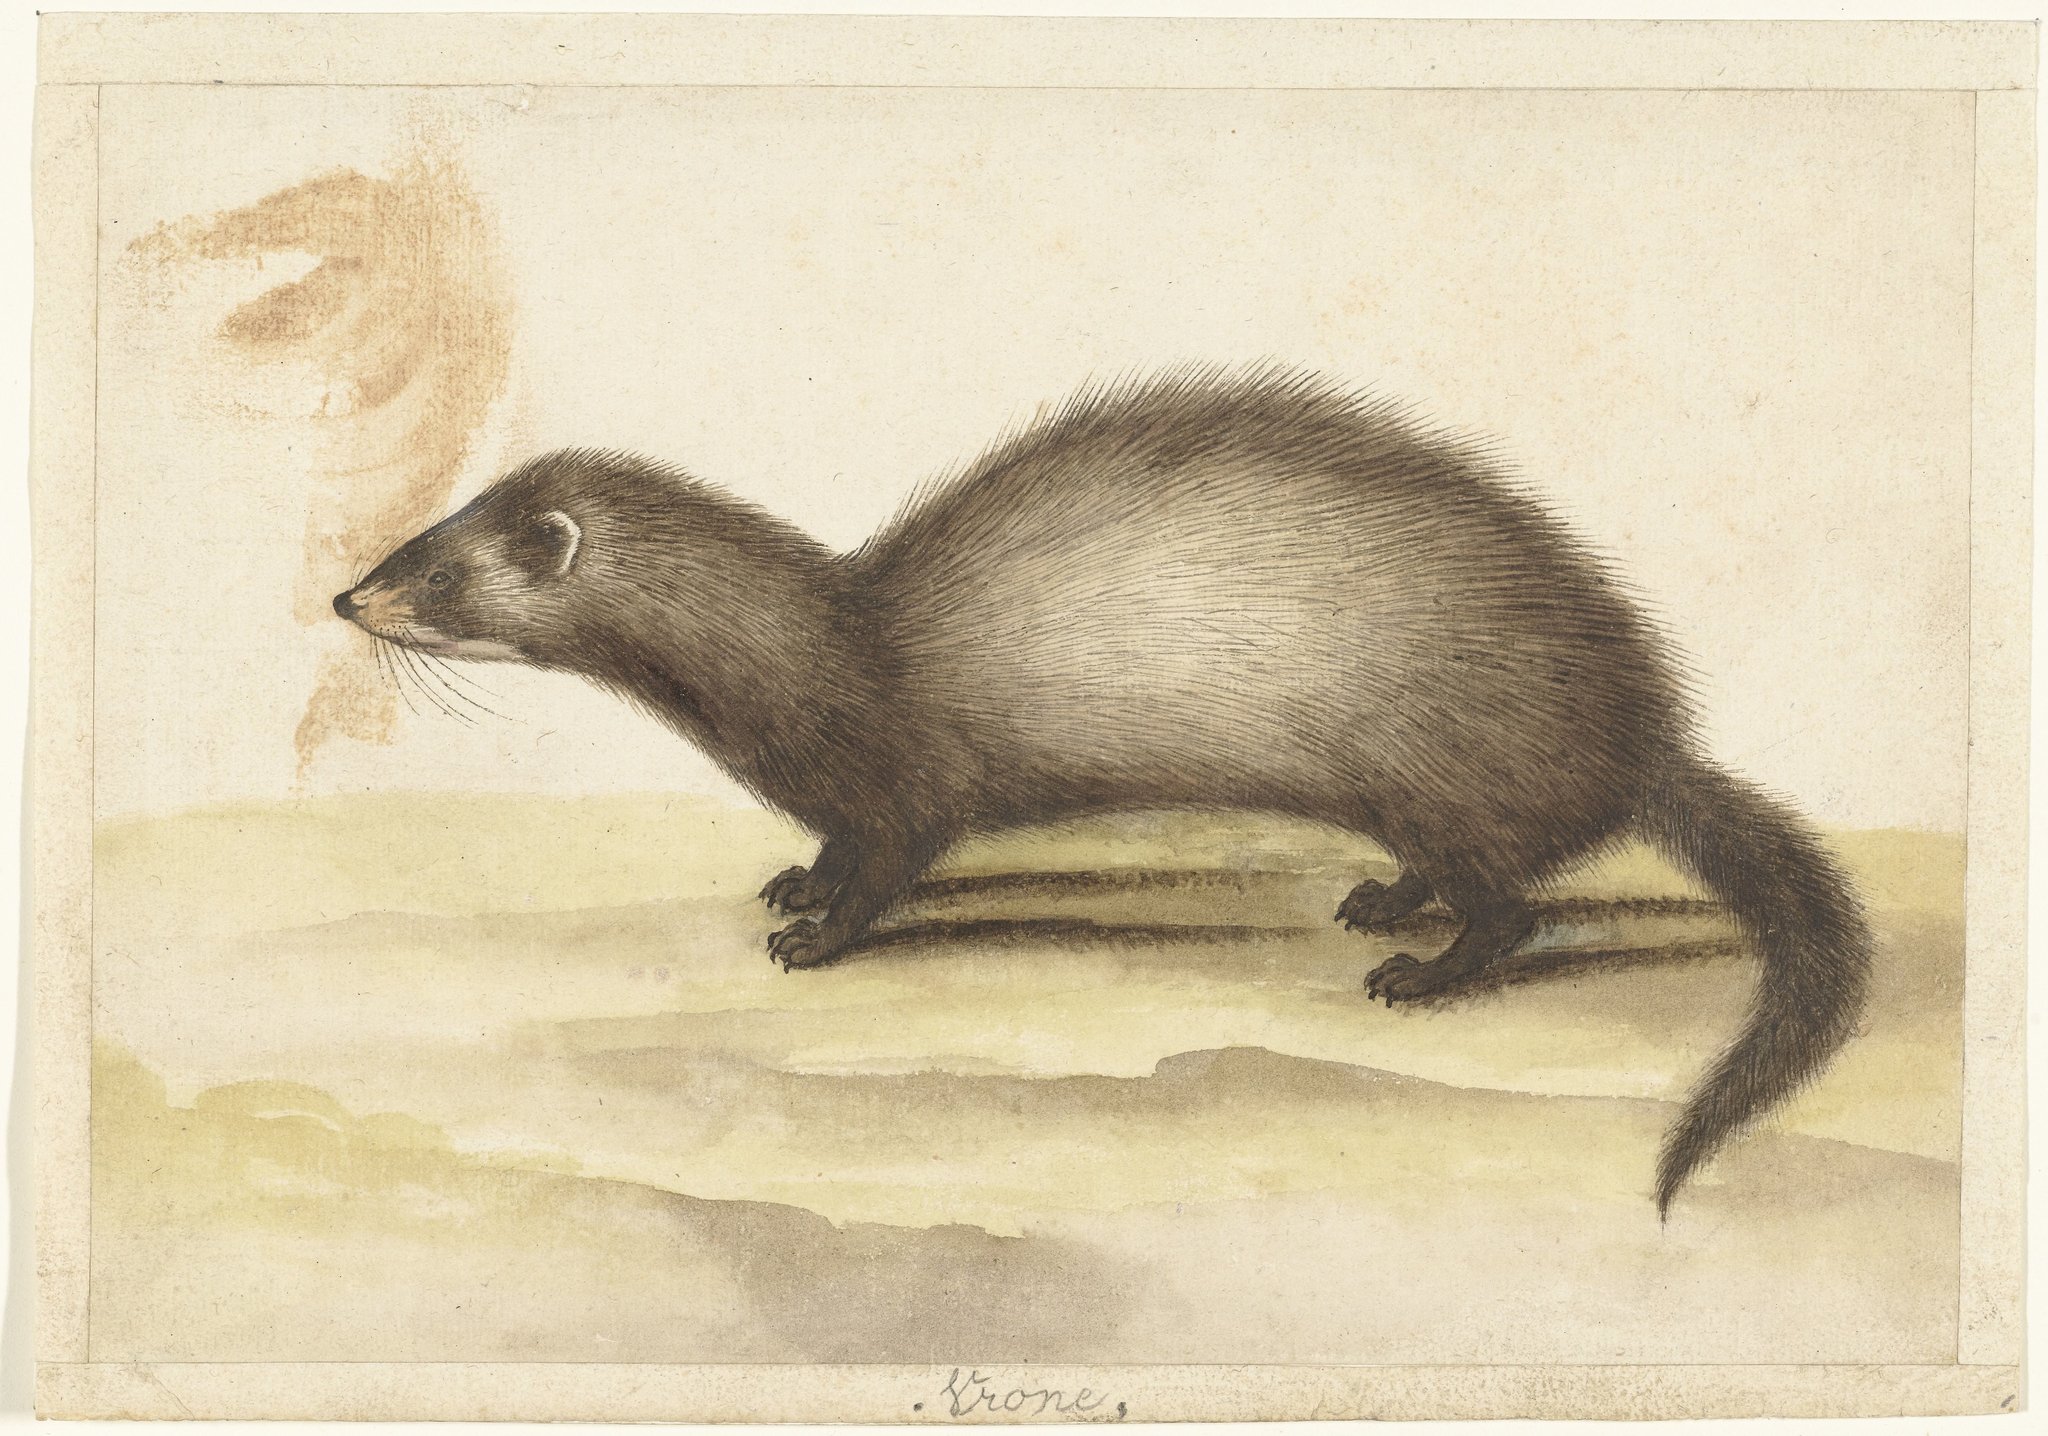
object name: drawing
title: Lombard album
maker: Anonymous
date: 1560-1585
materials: ink, paper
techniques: brush, pen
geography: low countries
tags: beasts of prey, predatory animals: polecat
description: Blad uit album van 100 (?) bladen met tekeningen van dieren.